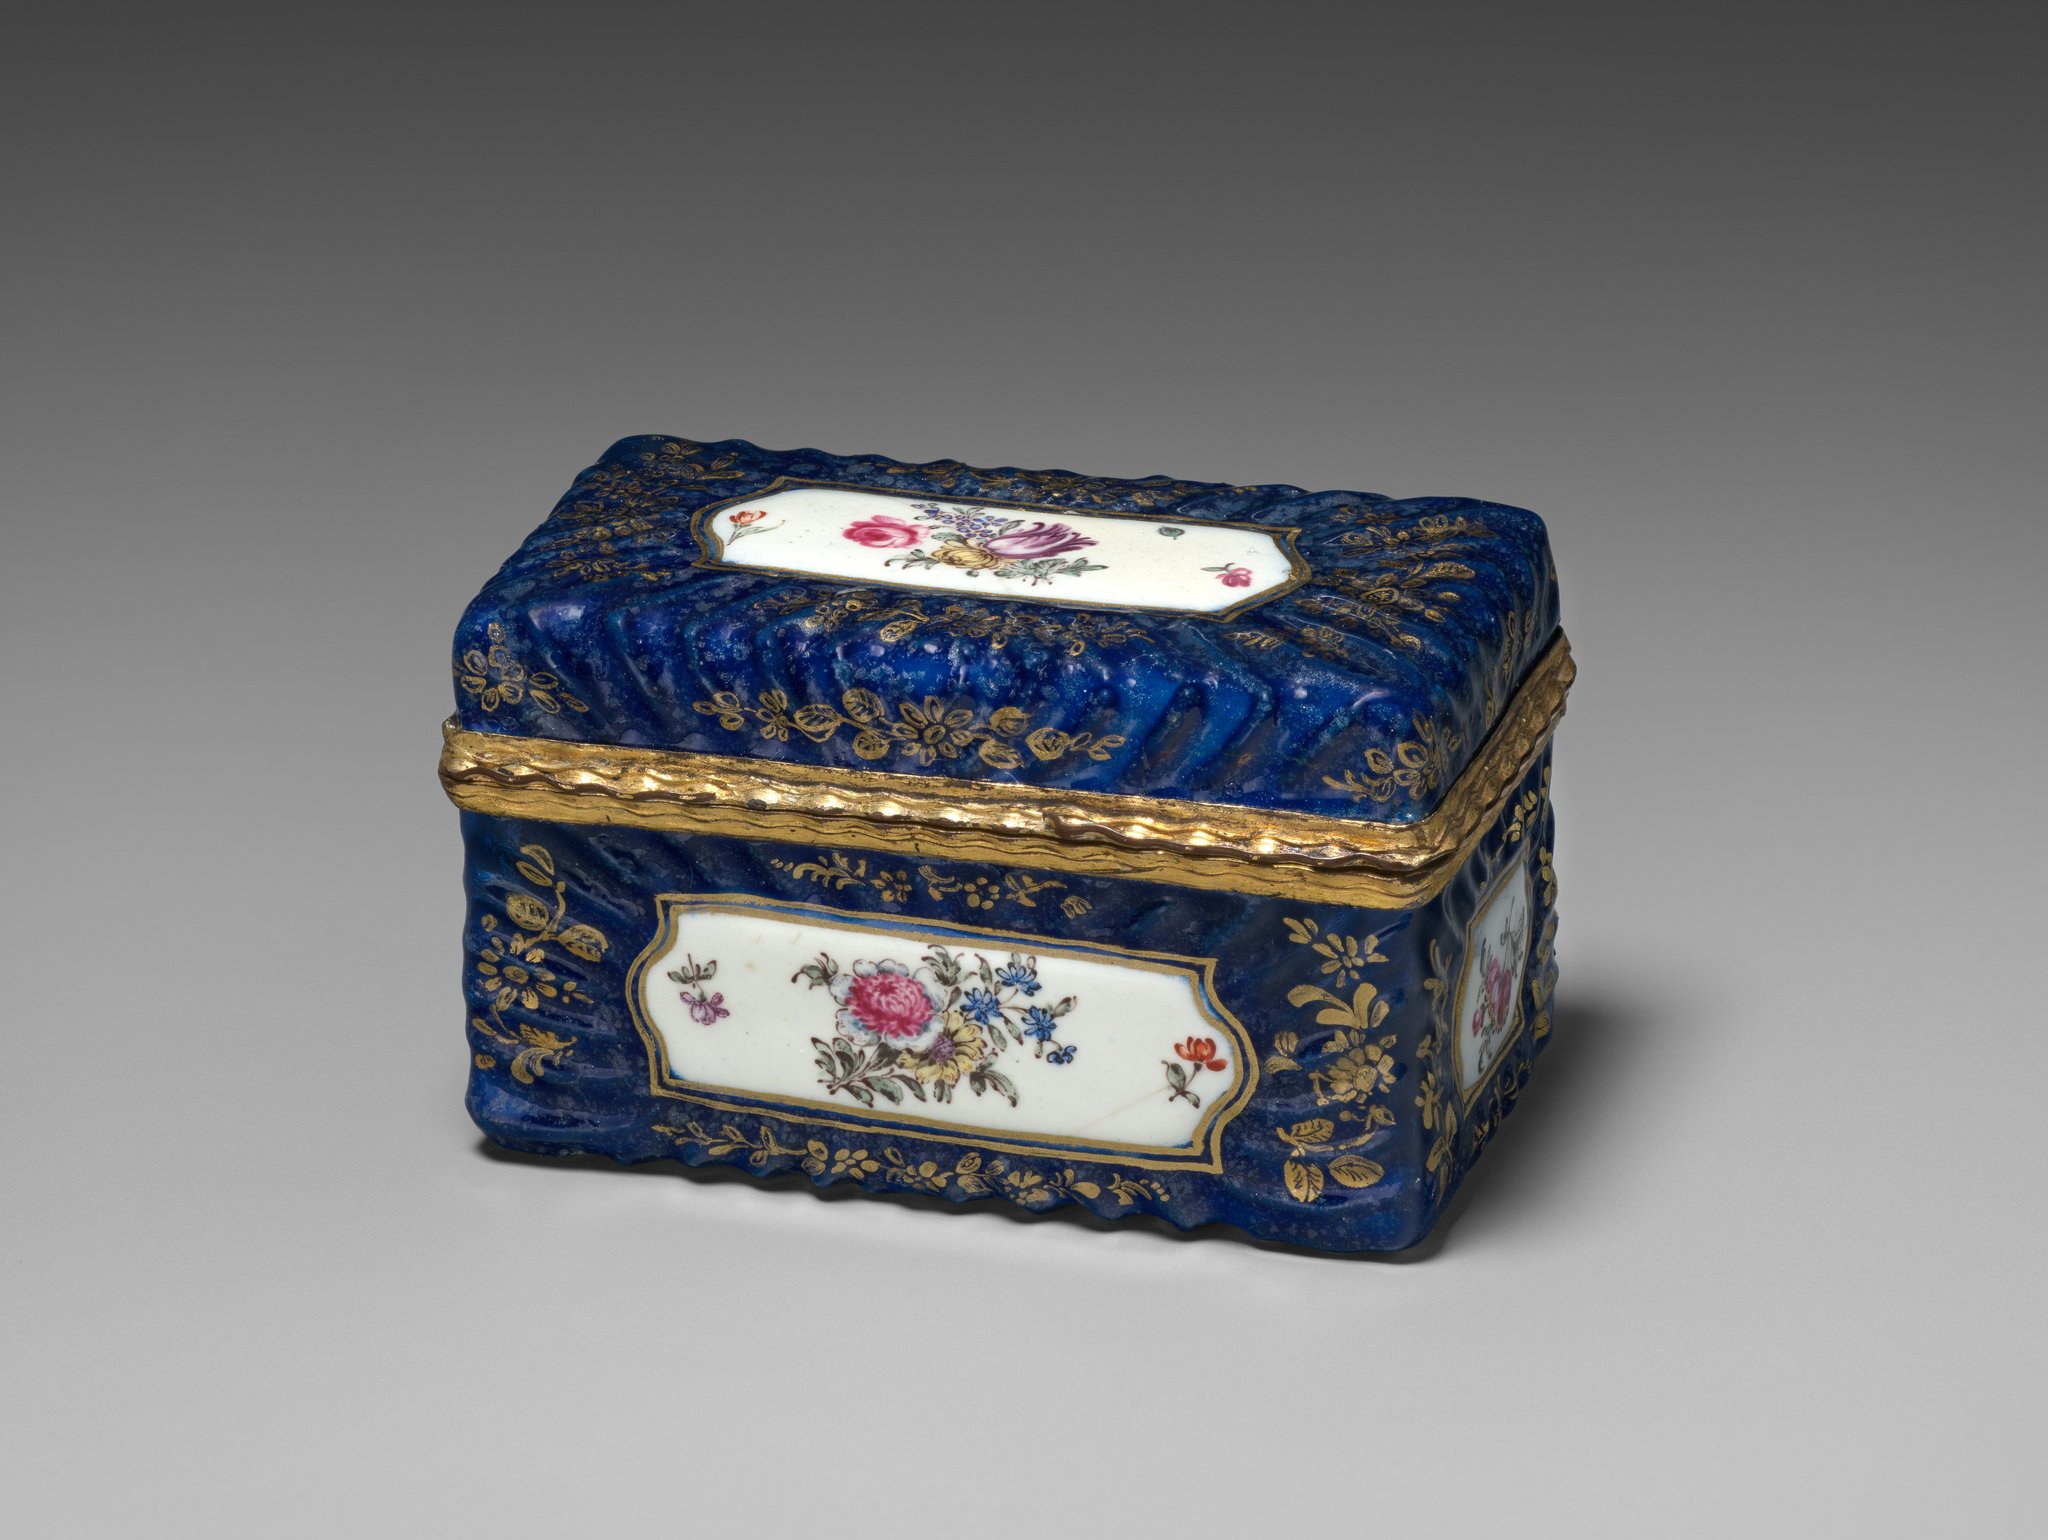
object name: snuffbox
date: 1750-1759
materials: copper, enamel